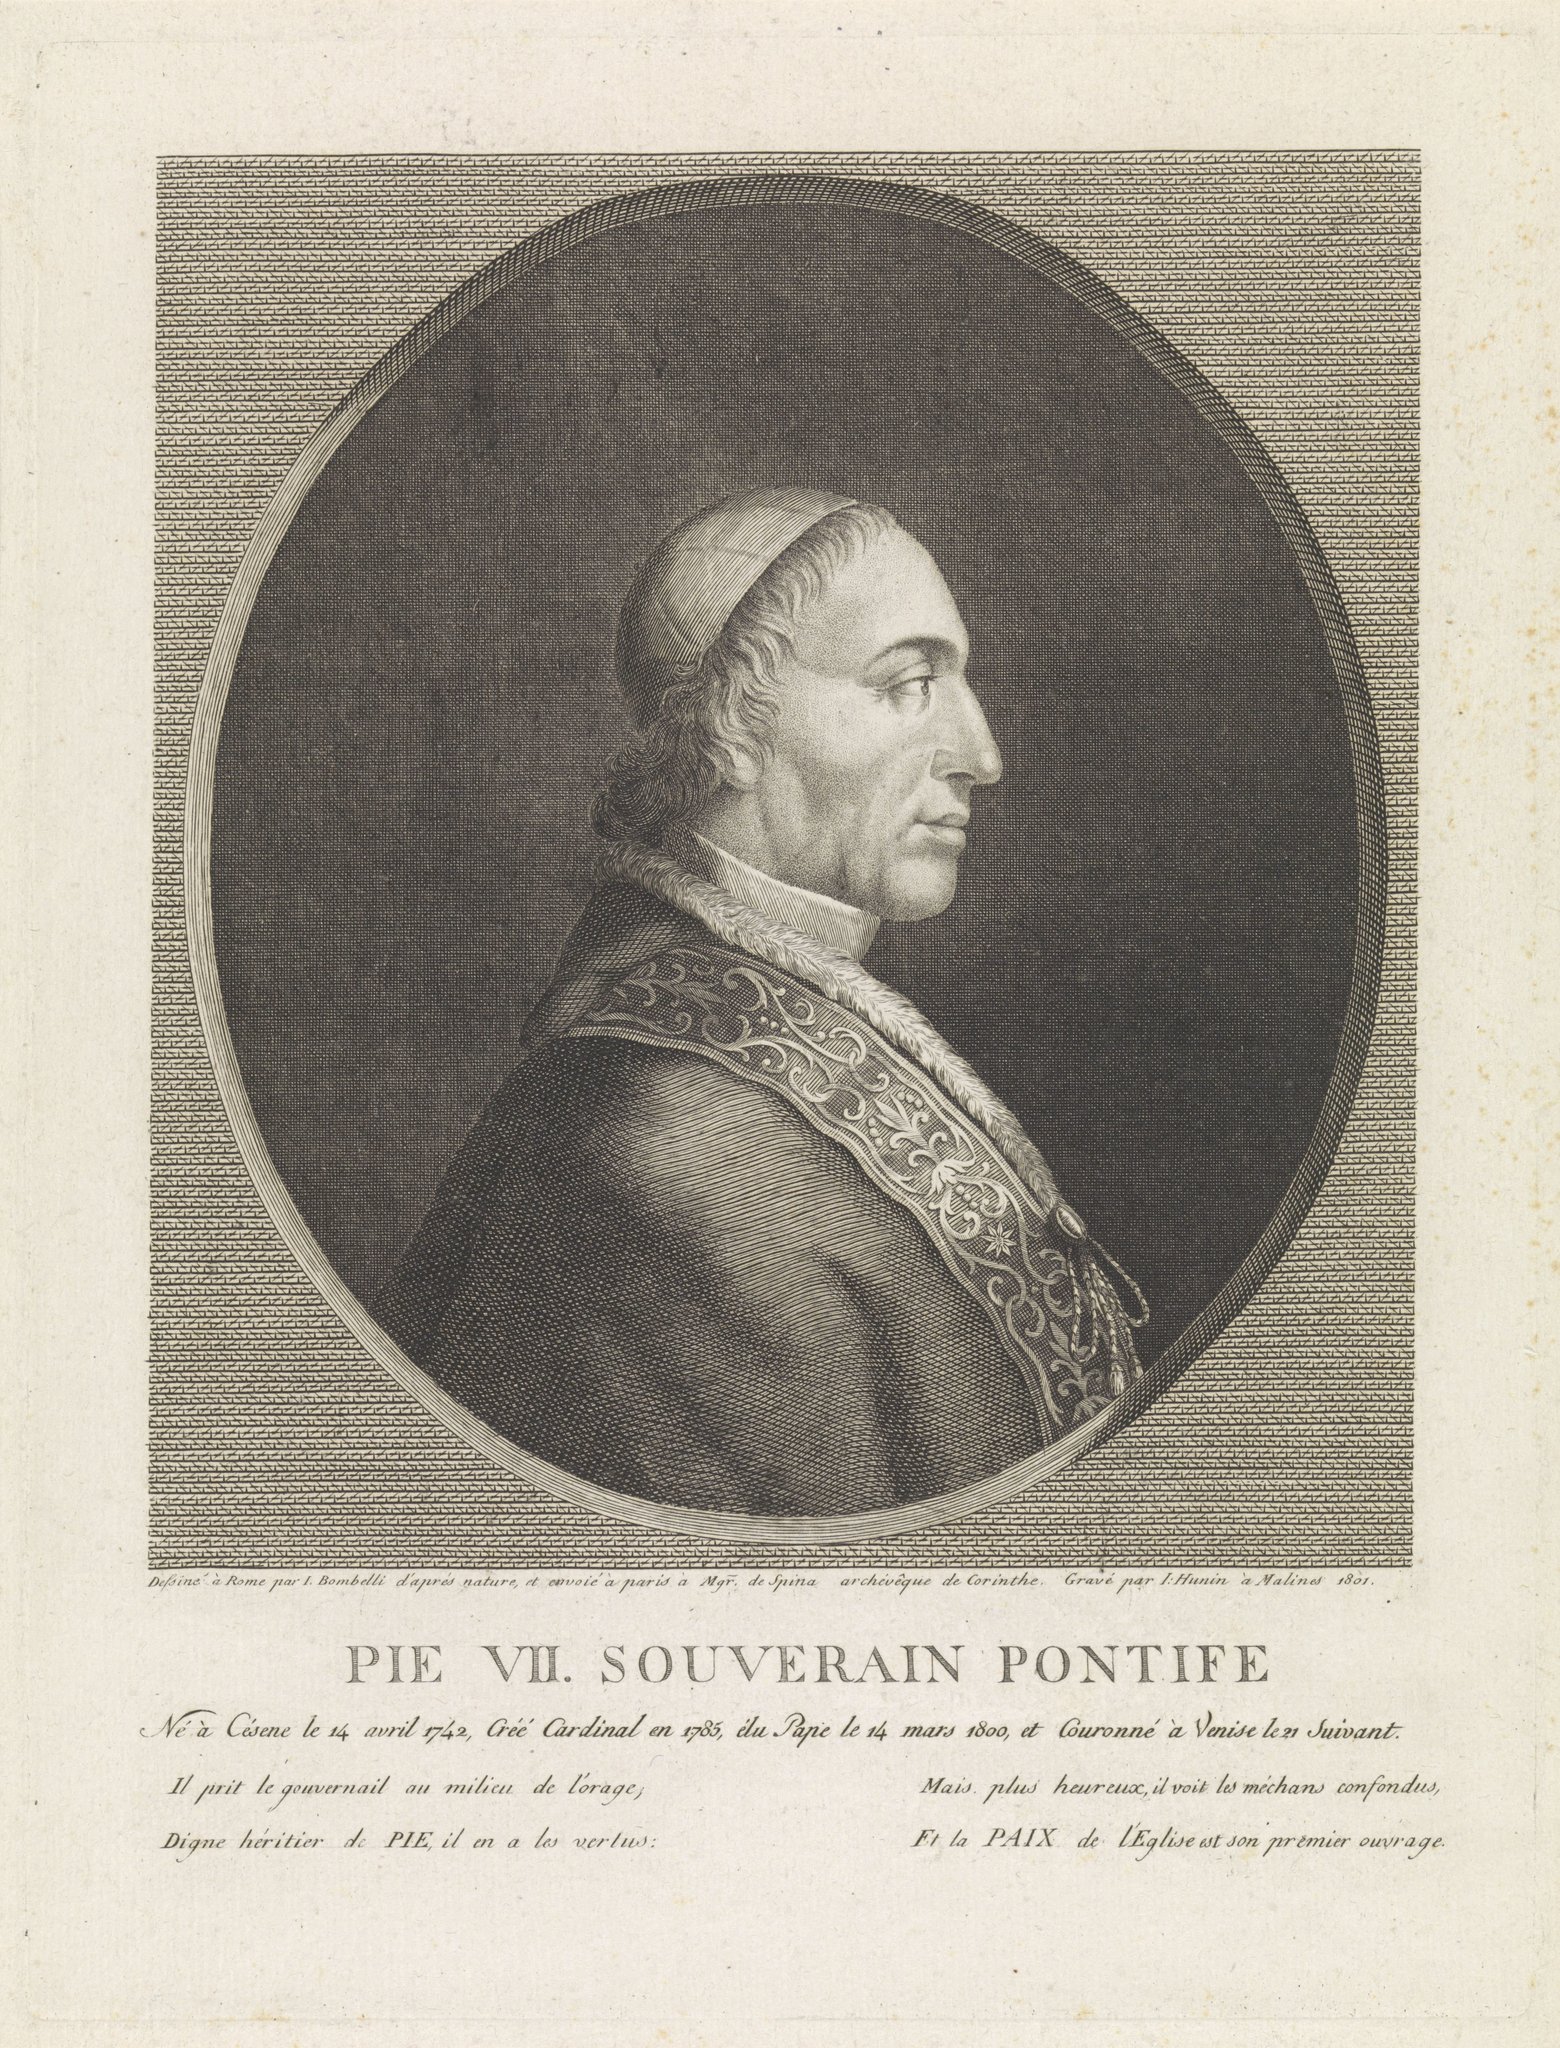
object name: print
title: Portret van paus Pius VII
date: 1801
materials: paper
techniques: engraving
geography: mechelen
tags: rome, clergyman, pius vii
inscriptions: collector's mark: Lugt 2228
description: Paus Pius VII, gehuld in zijn pauselijk gewaad, kalot op het hoofd. Buste en profil naar rechts in ovaal. Onder de titel één tekstregel en een vierregelig vers in het Frans.